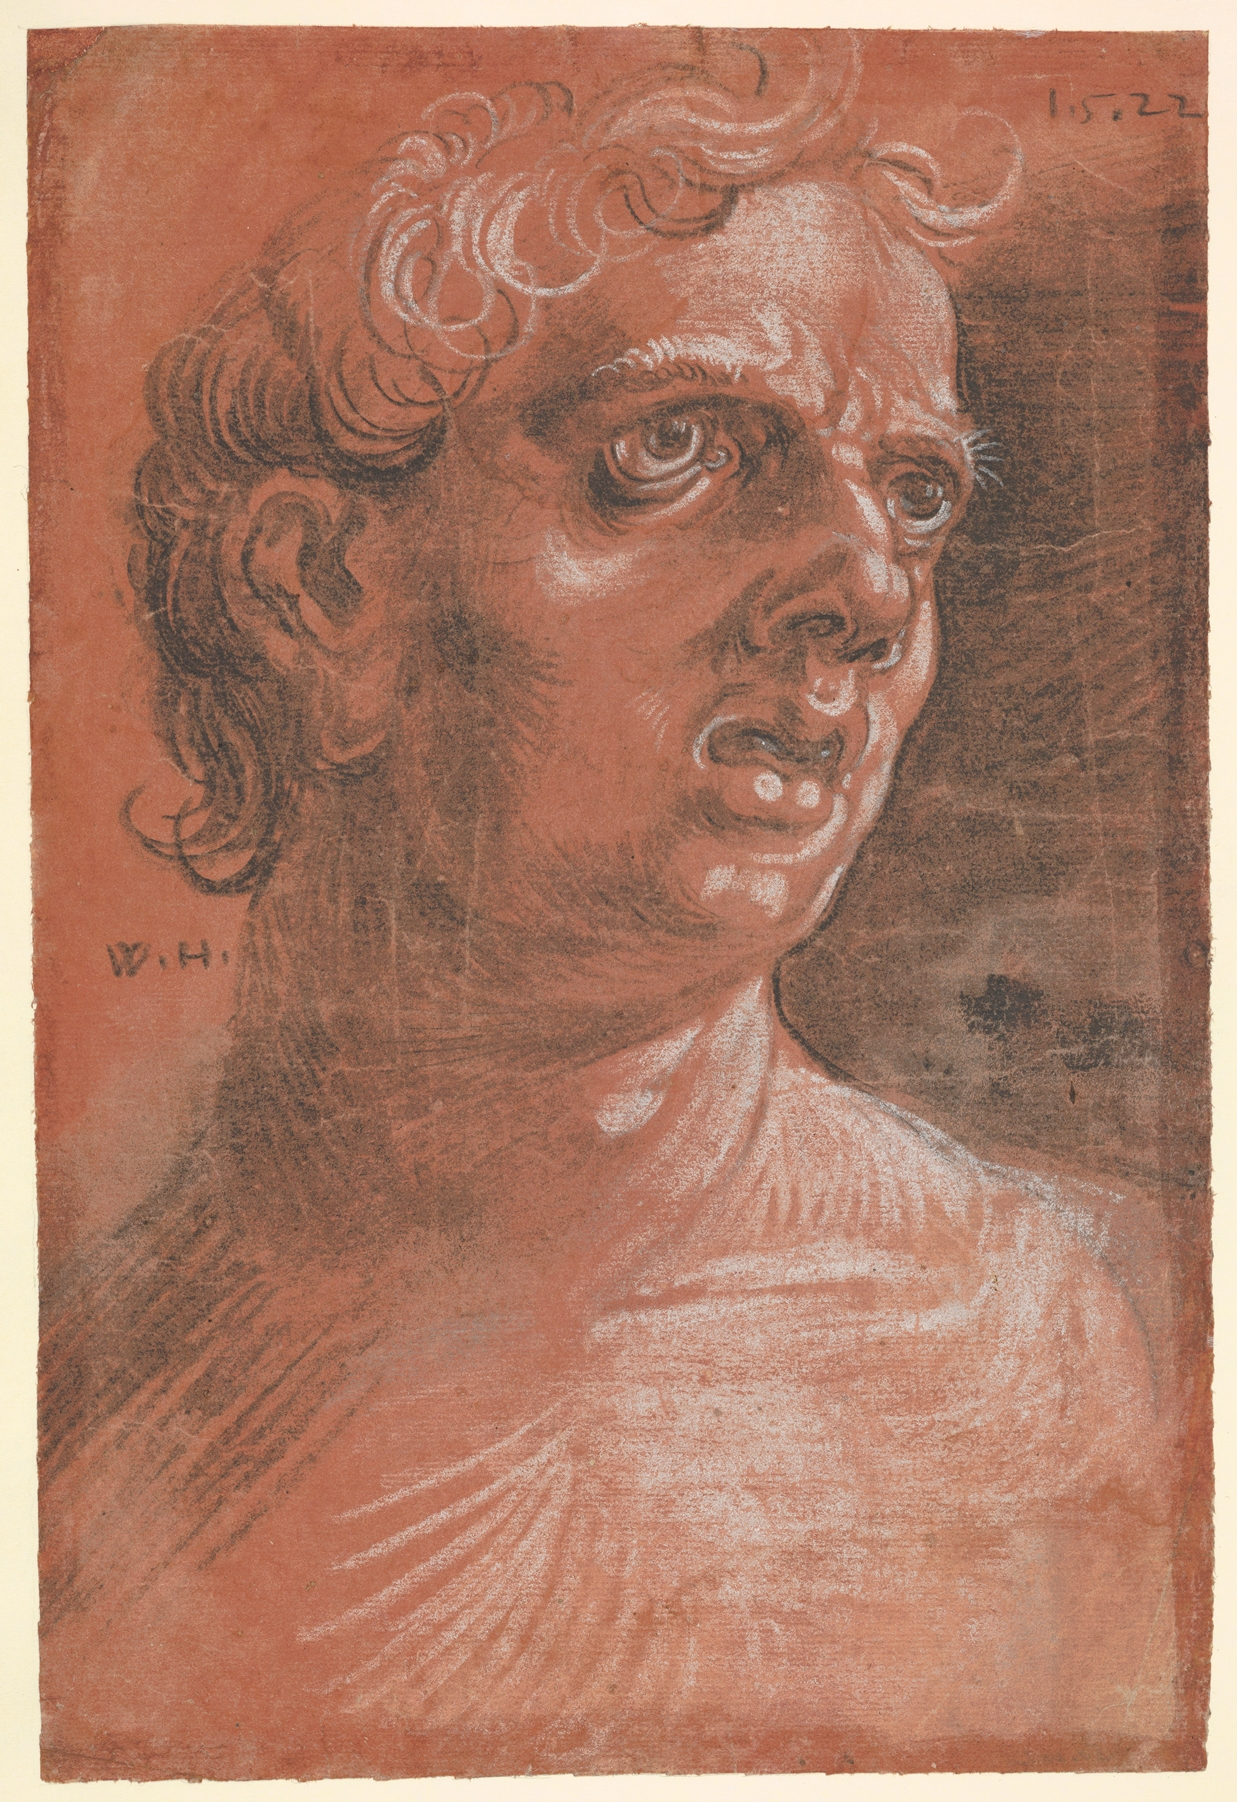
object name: drawing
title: Bust of a Man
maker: wolfgang huber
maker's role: artist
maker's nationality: german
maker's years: 1485-1553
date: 1522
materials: chalk, gouache, paper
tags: men,portraits